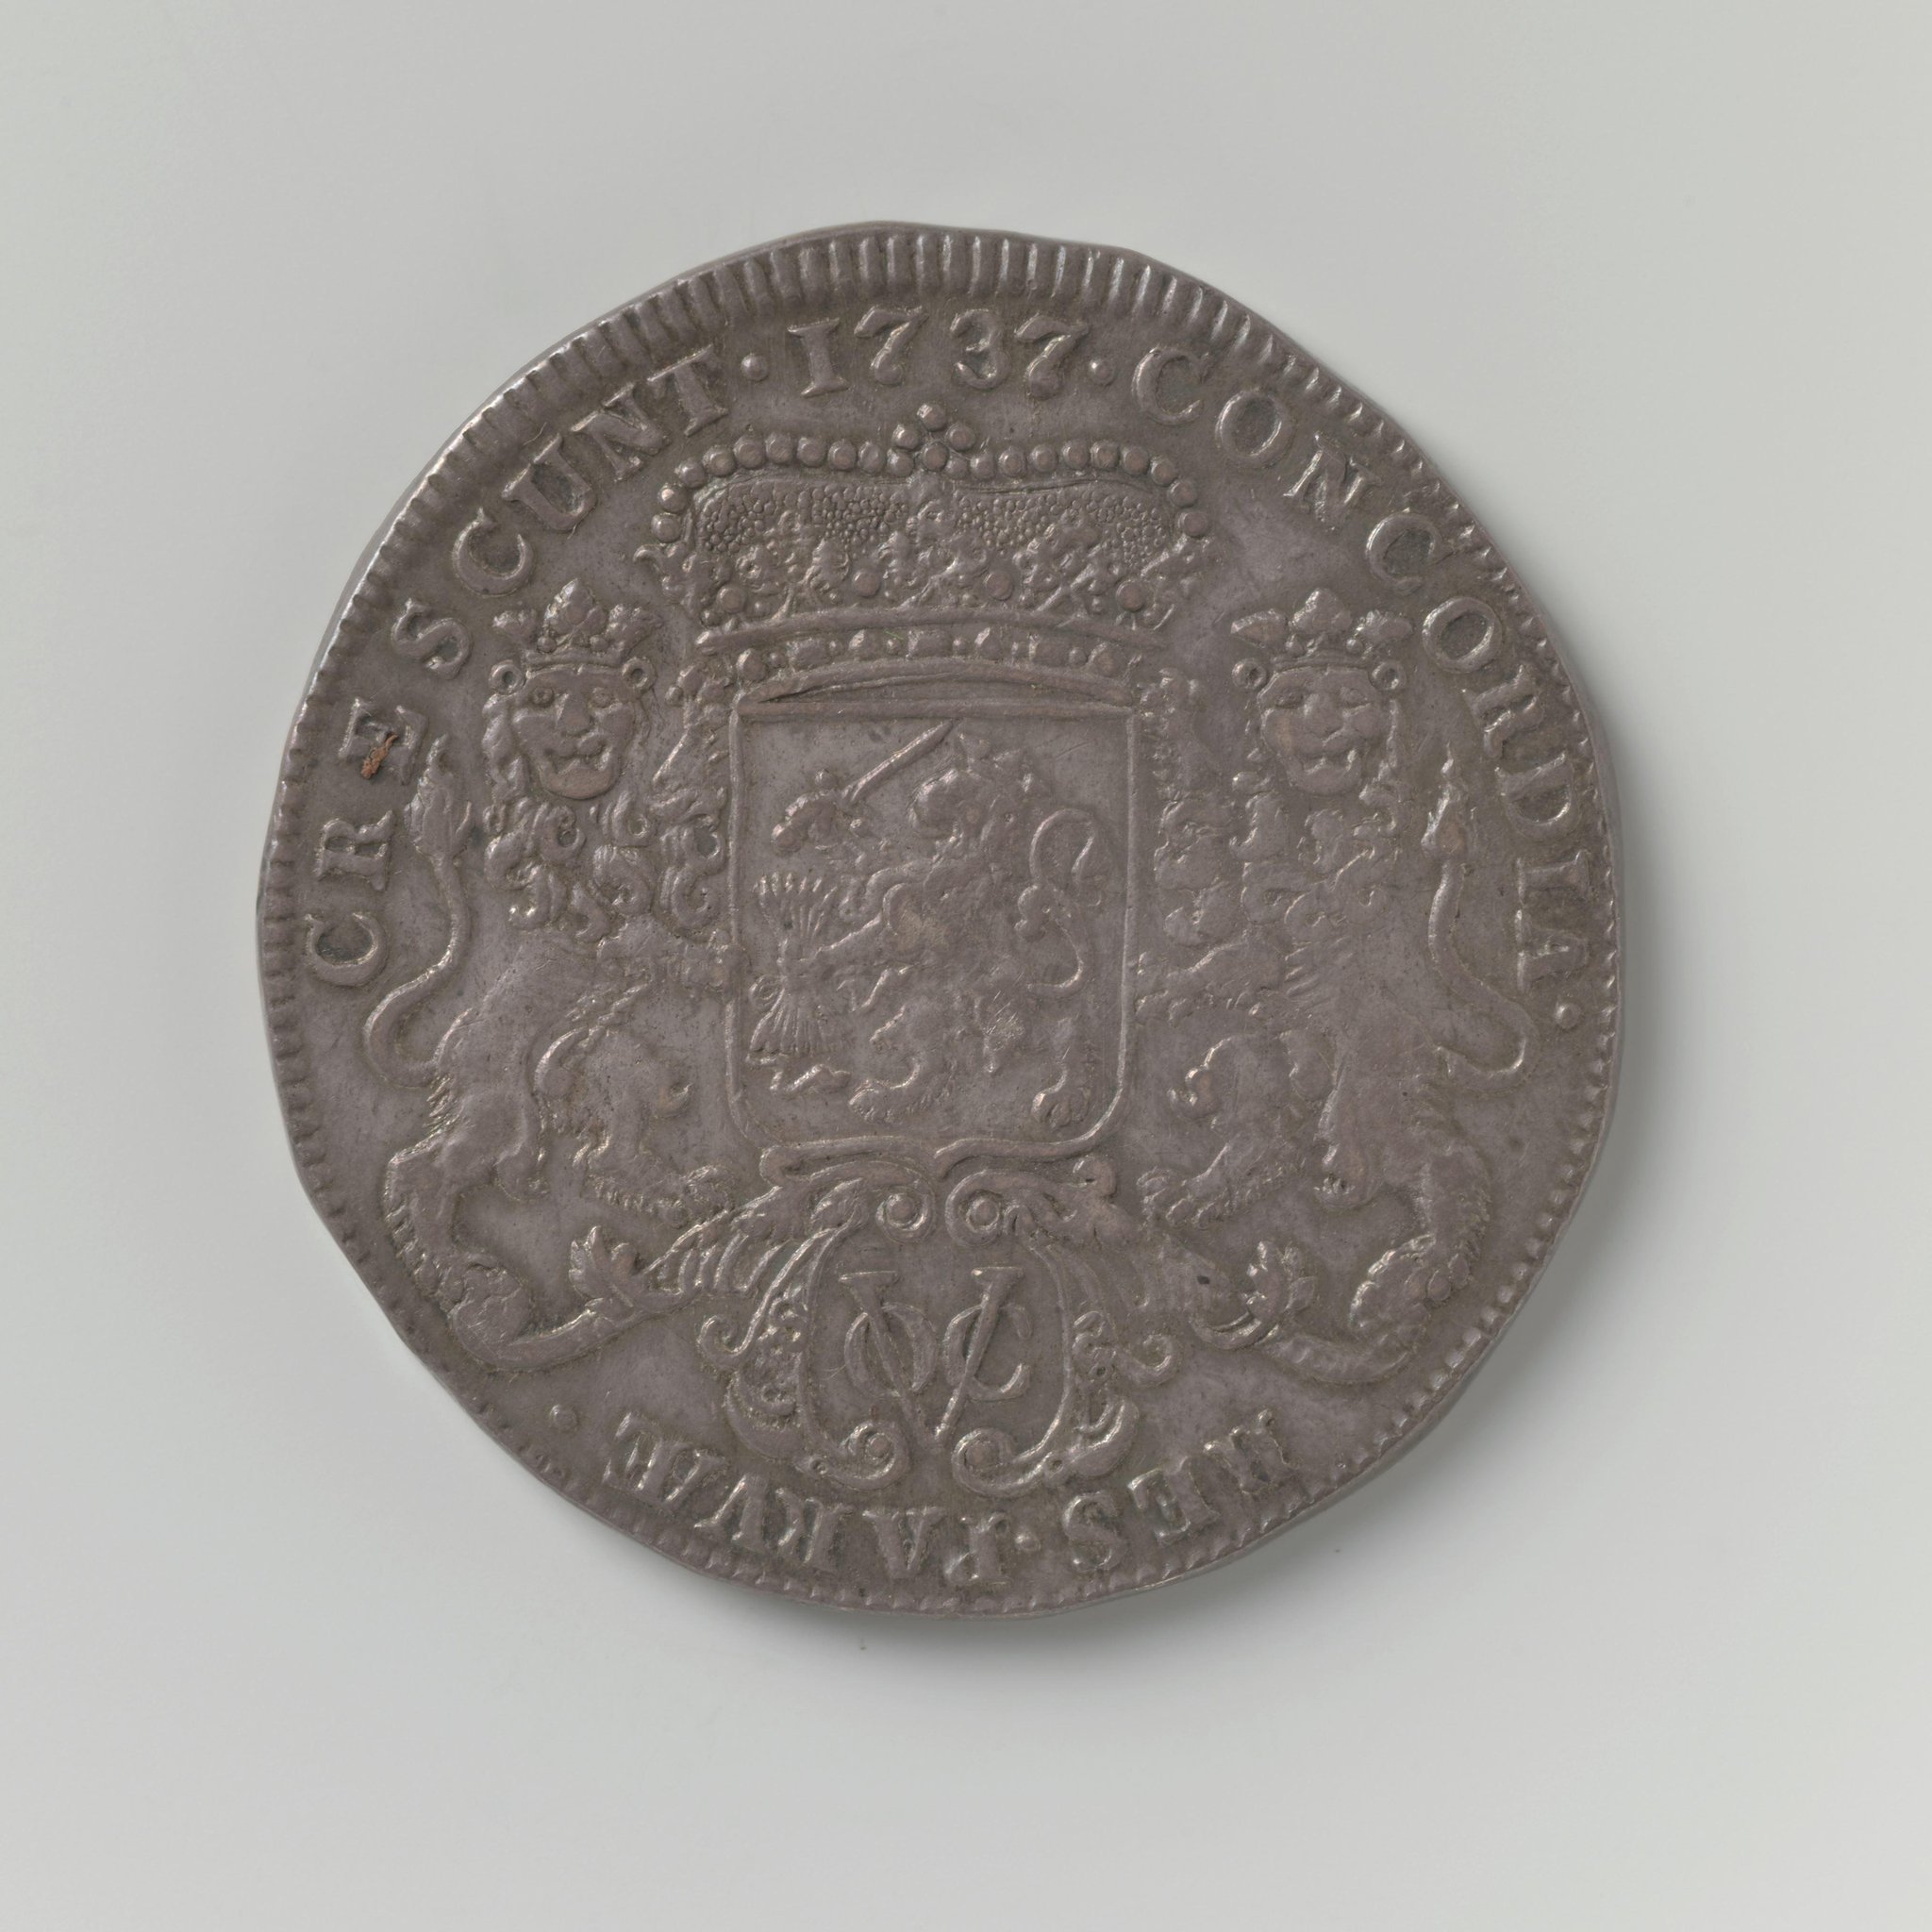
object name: silver rider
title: Zilveren rijder van de VOC uit Overijssel, 1737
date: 1737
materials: silver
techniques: striking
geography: kampen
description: Zilveren munt. Voorzijde: geharnaste ridder met zwaard te paard naar rechts, waaronder gekroond wapenschild van Overijssel. Keerzijde: gekroond generaliteitswapenschild, waaronder cartouche, waarin monogram van de VOC. Jaartal in omschrift, boven kroon. Gladde rand.